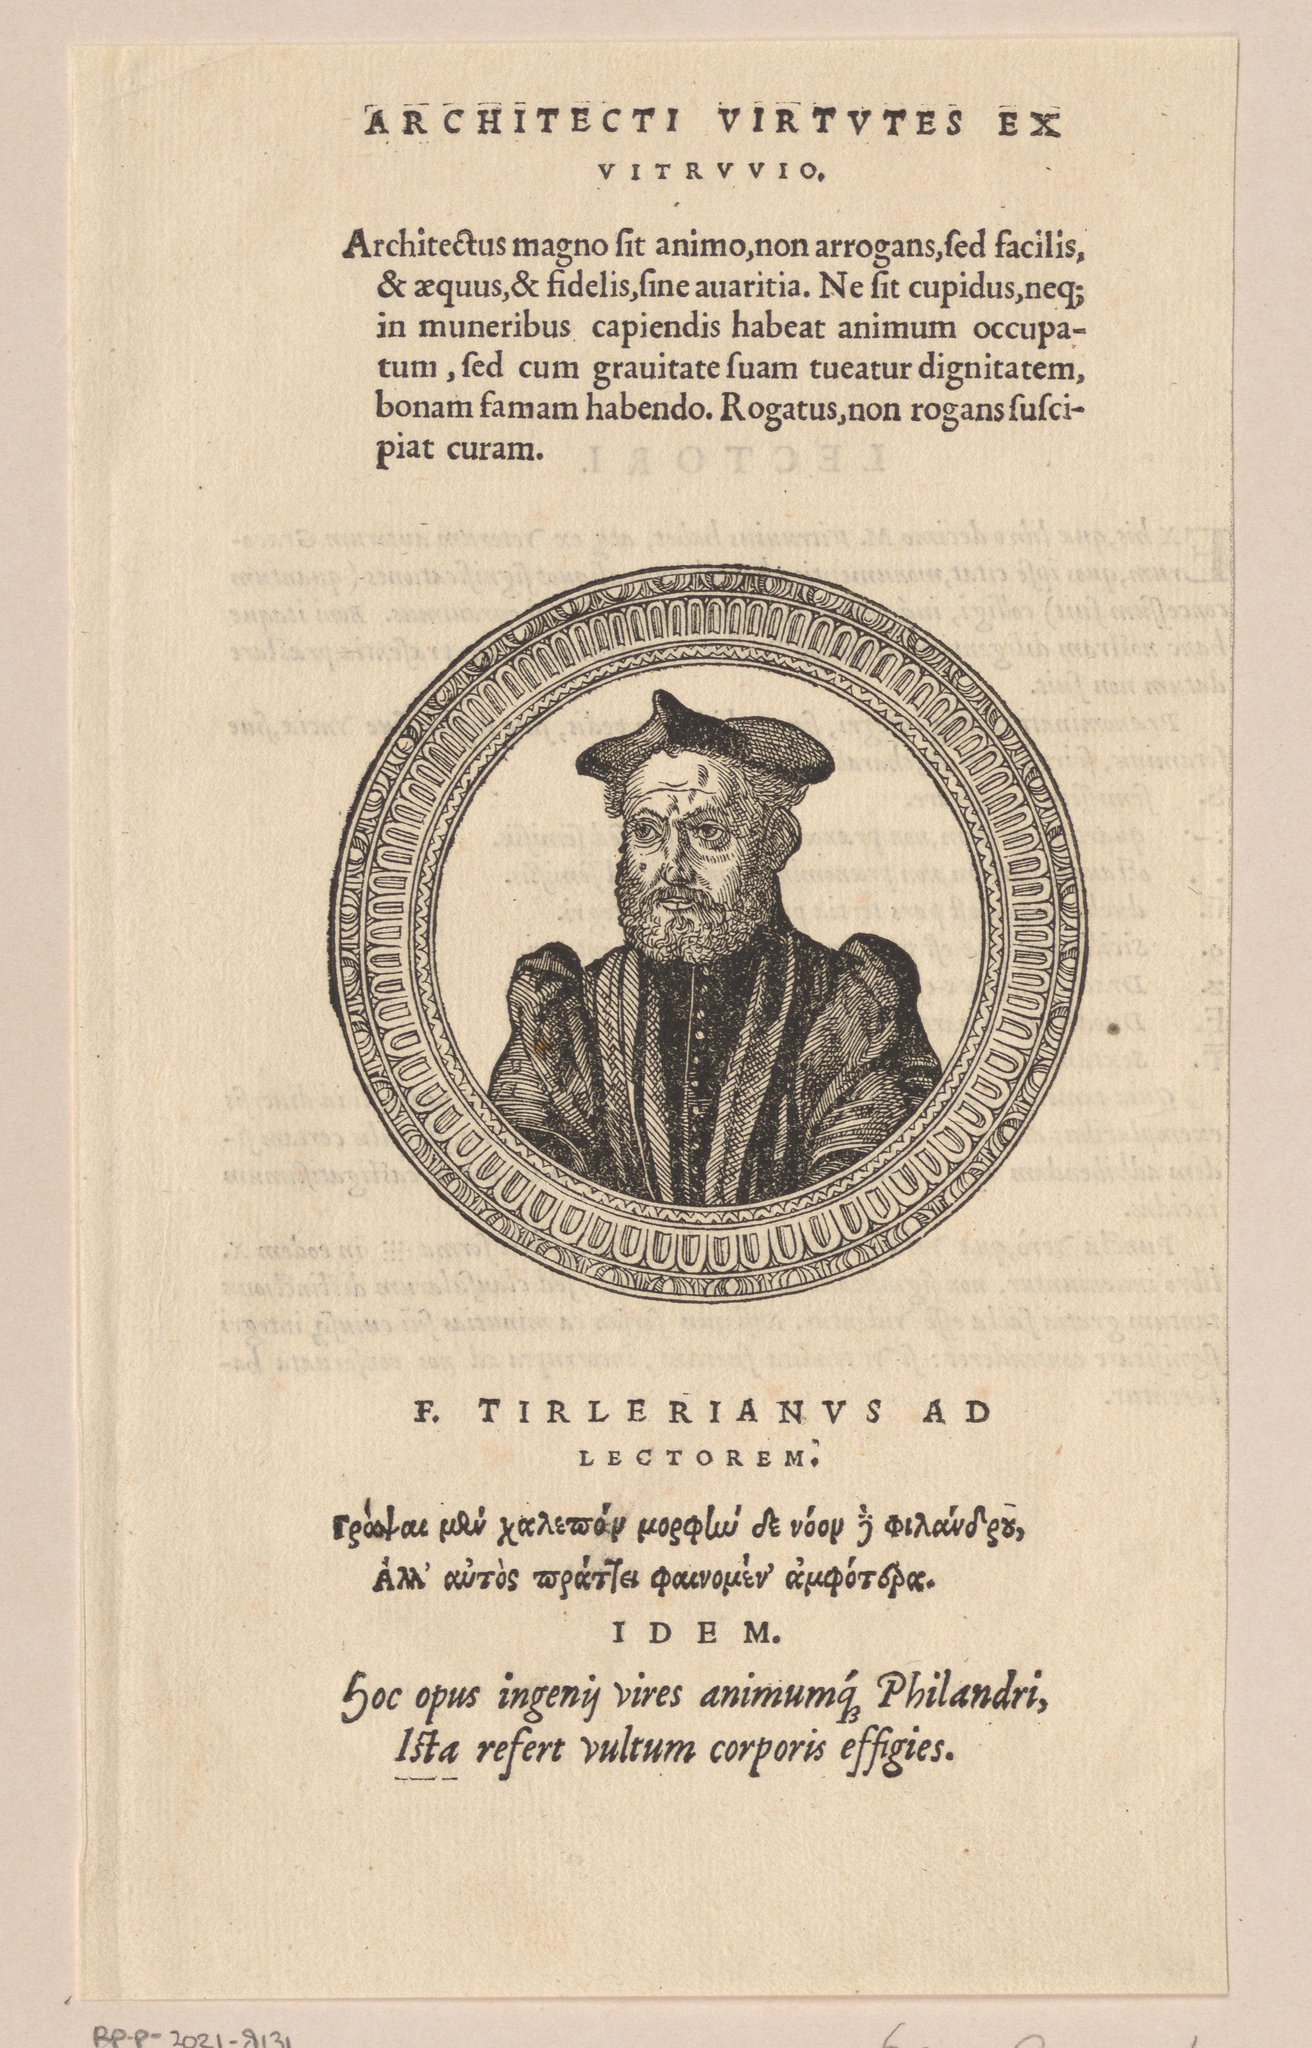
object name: print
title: Portret van Guillaume Philandrier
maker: bernard salomon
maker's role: draughtsman, painter, print maker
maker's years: 1506-1570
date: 1552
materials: paper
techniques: letterpress printing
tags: priest, adult man, historical persons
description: Prent mogelijk uit: Pollio, Vitruvius. De architectura libri decem ad Caesarem Augustum (...). Lyon: Joan Tornaesium, 1552.